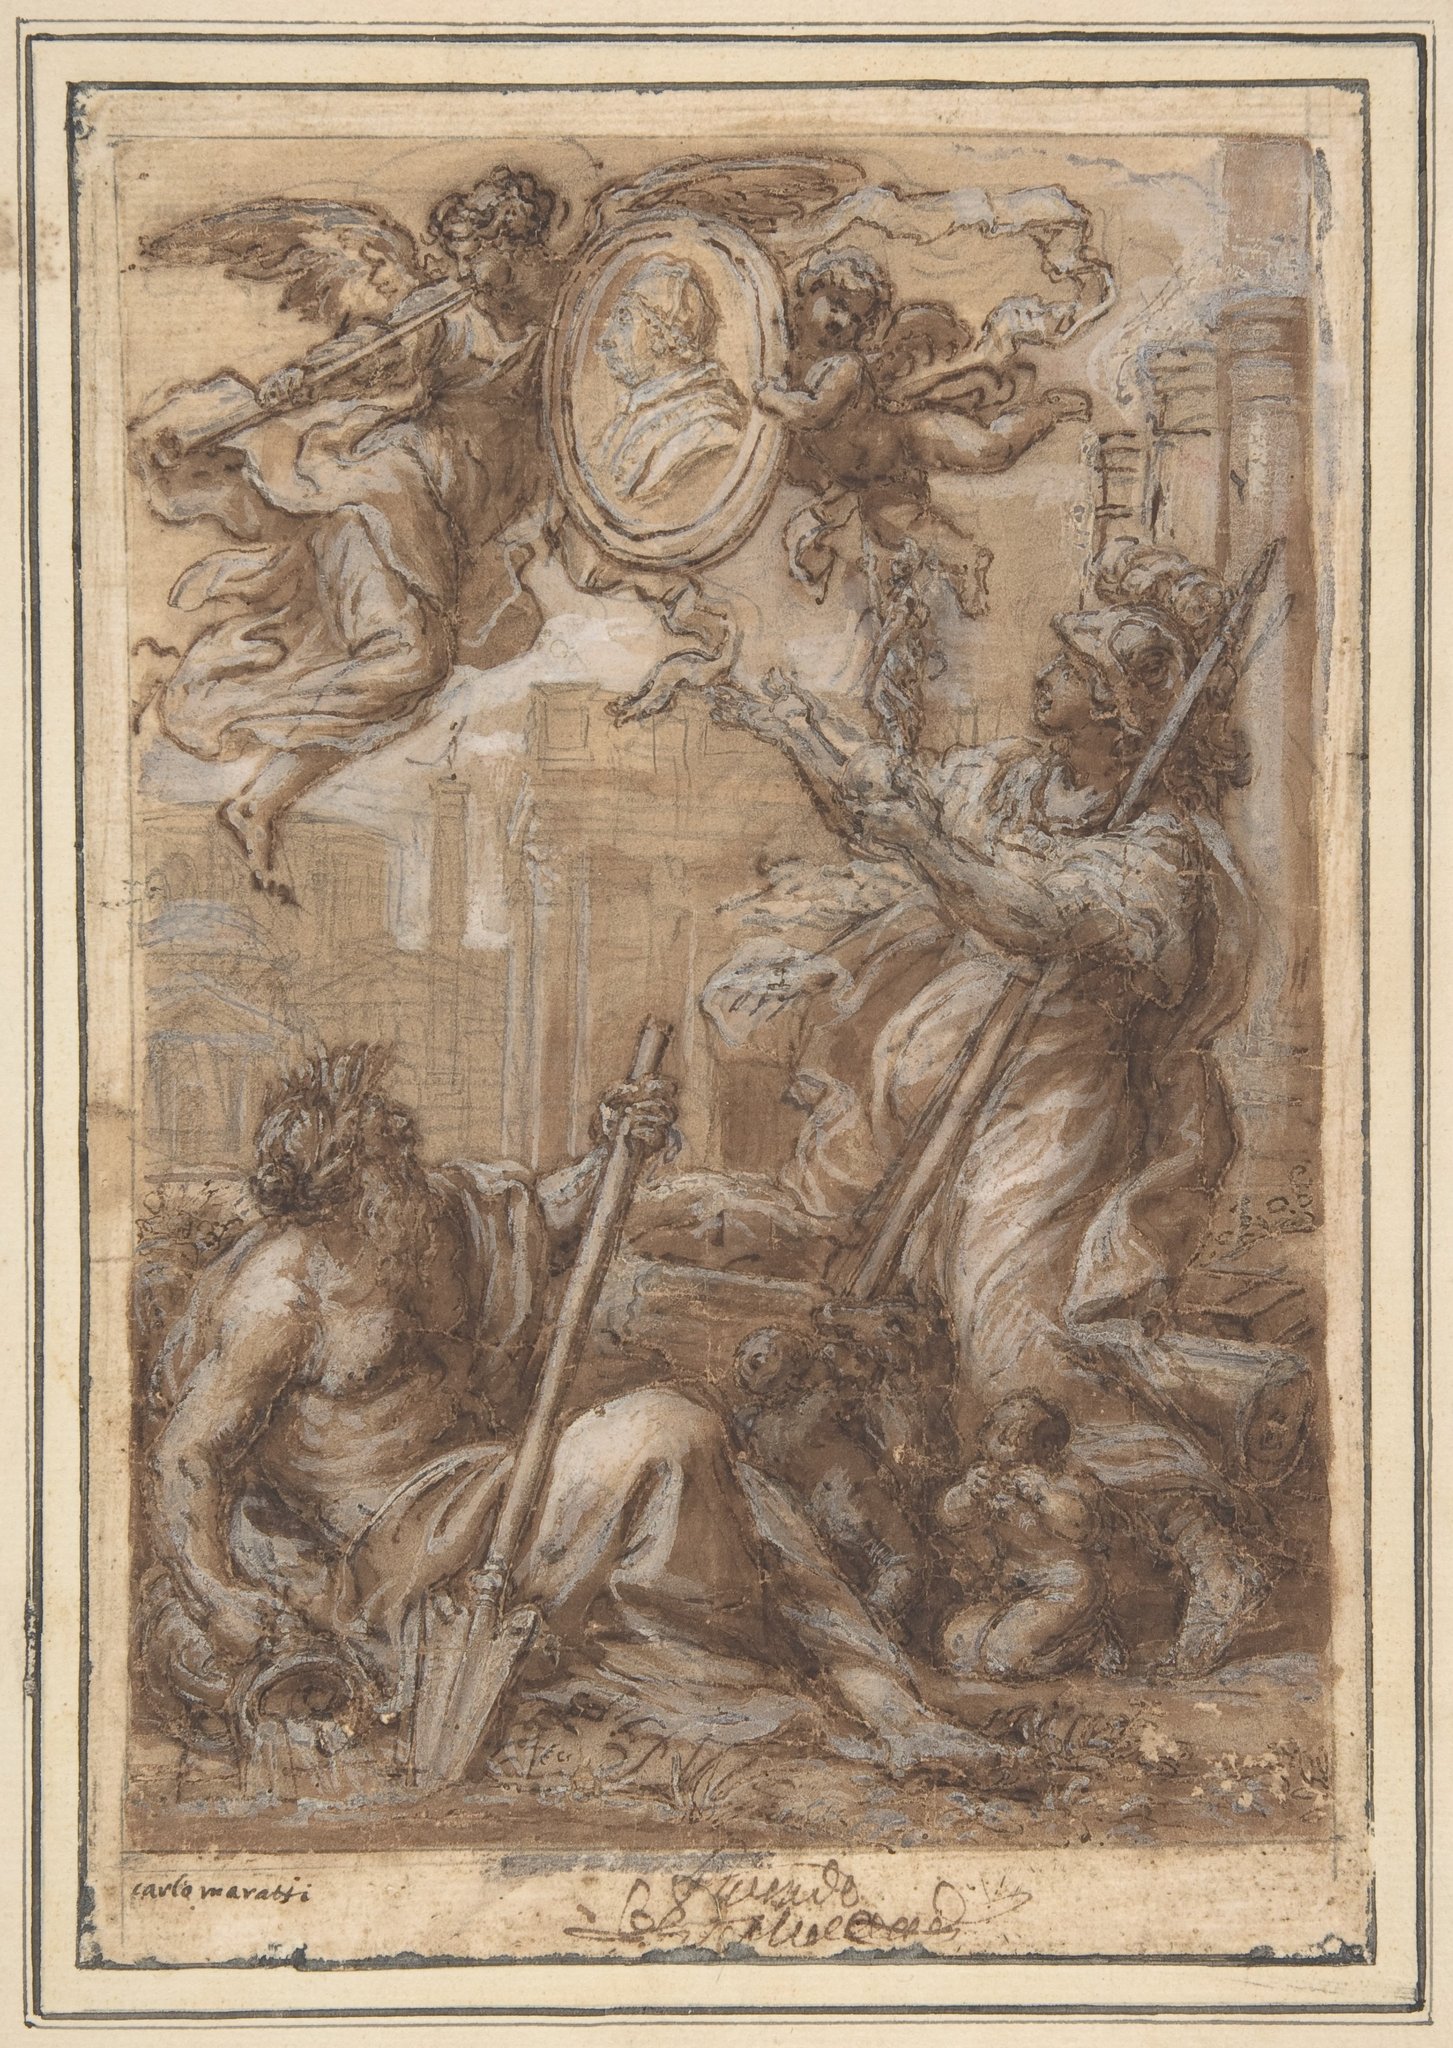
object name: drawing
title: Rome and the Tiber Paying Homage to a Pope (Clement XI ?)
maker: carlo maratti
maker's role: artist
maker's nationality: italian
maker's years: 1625-1713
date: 1625-1713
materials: chalk, ink, paper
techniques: brush, highlighting, pen, wash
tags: musical instruments,angels,popes